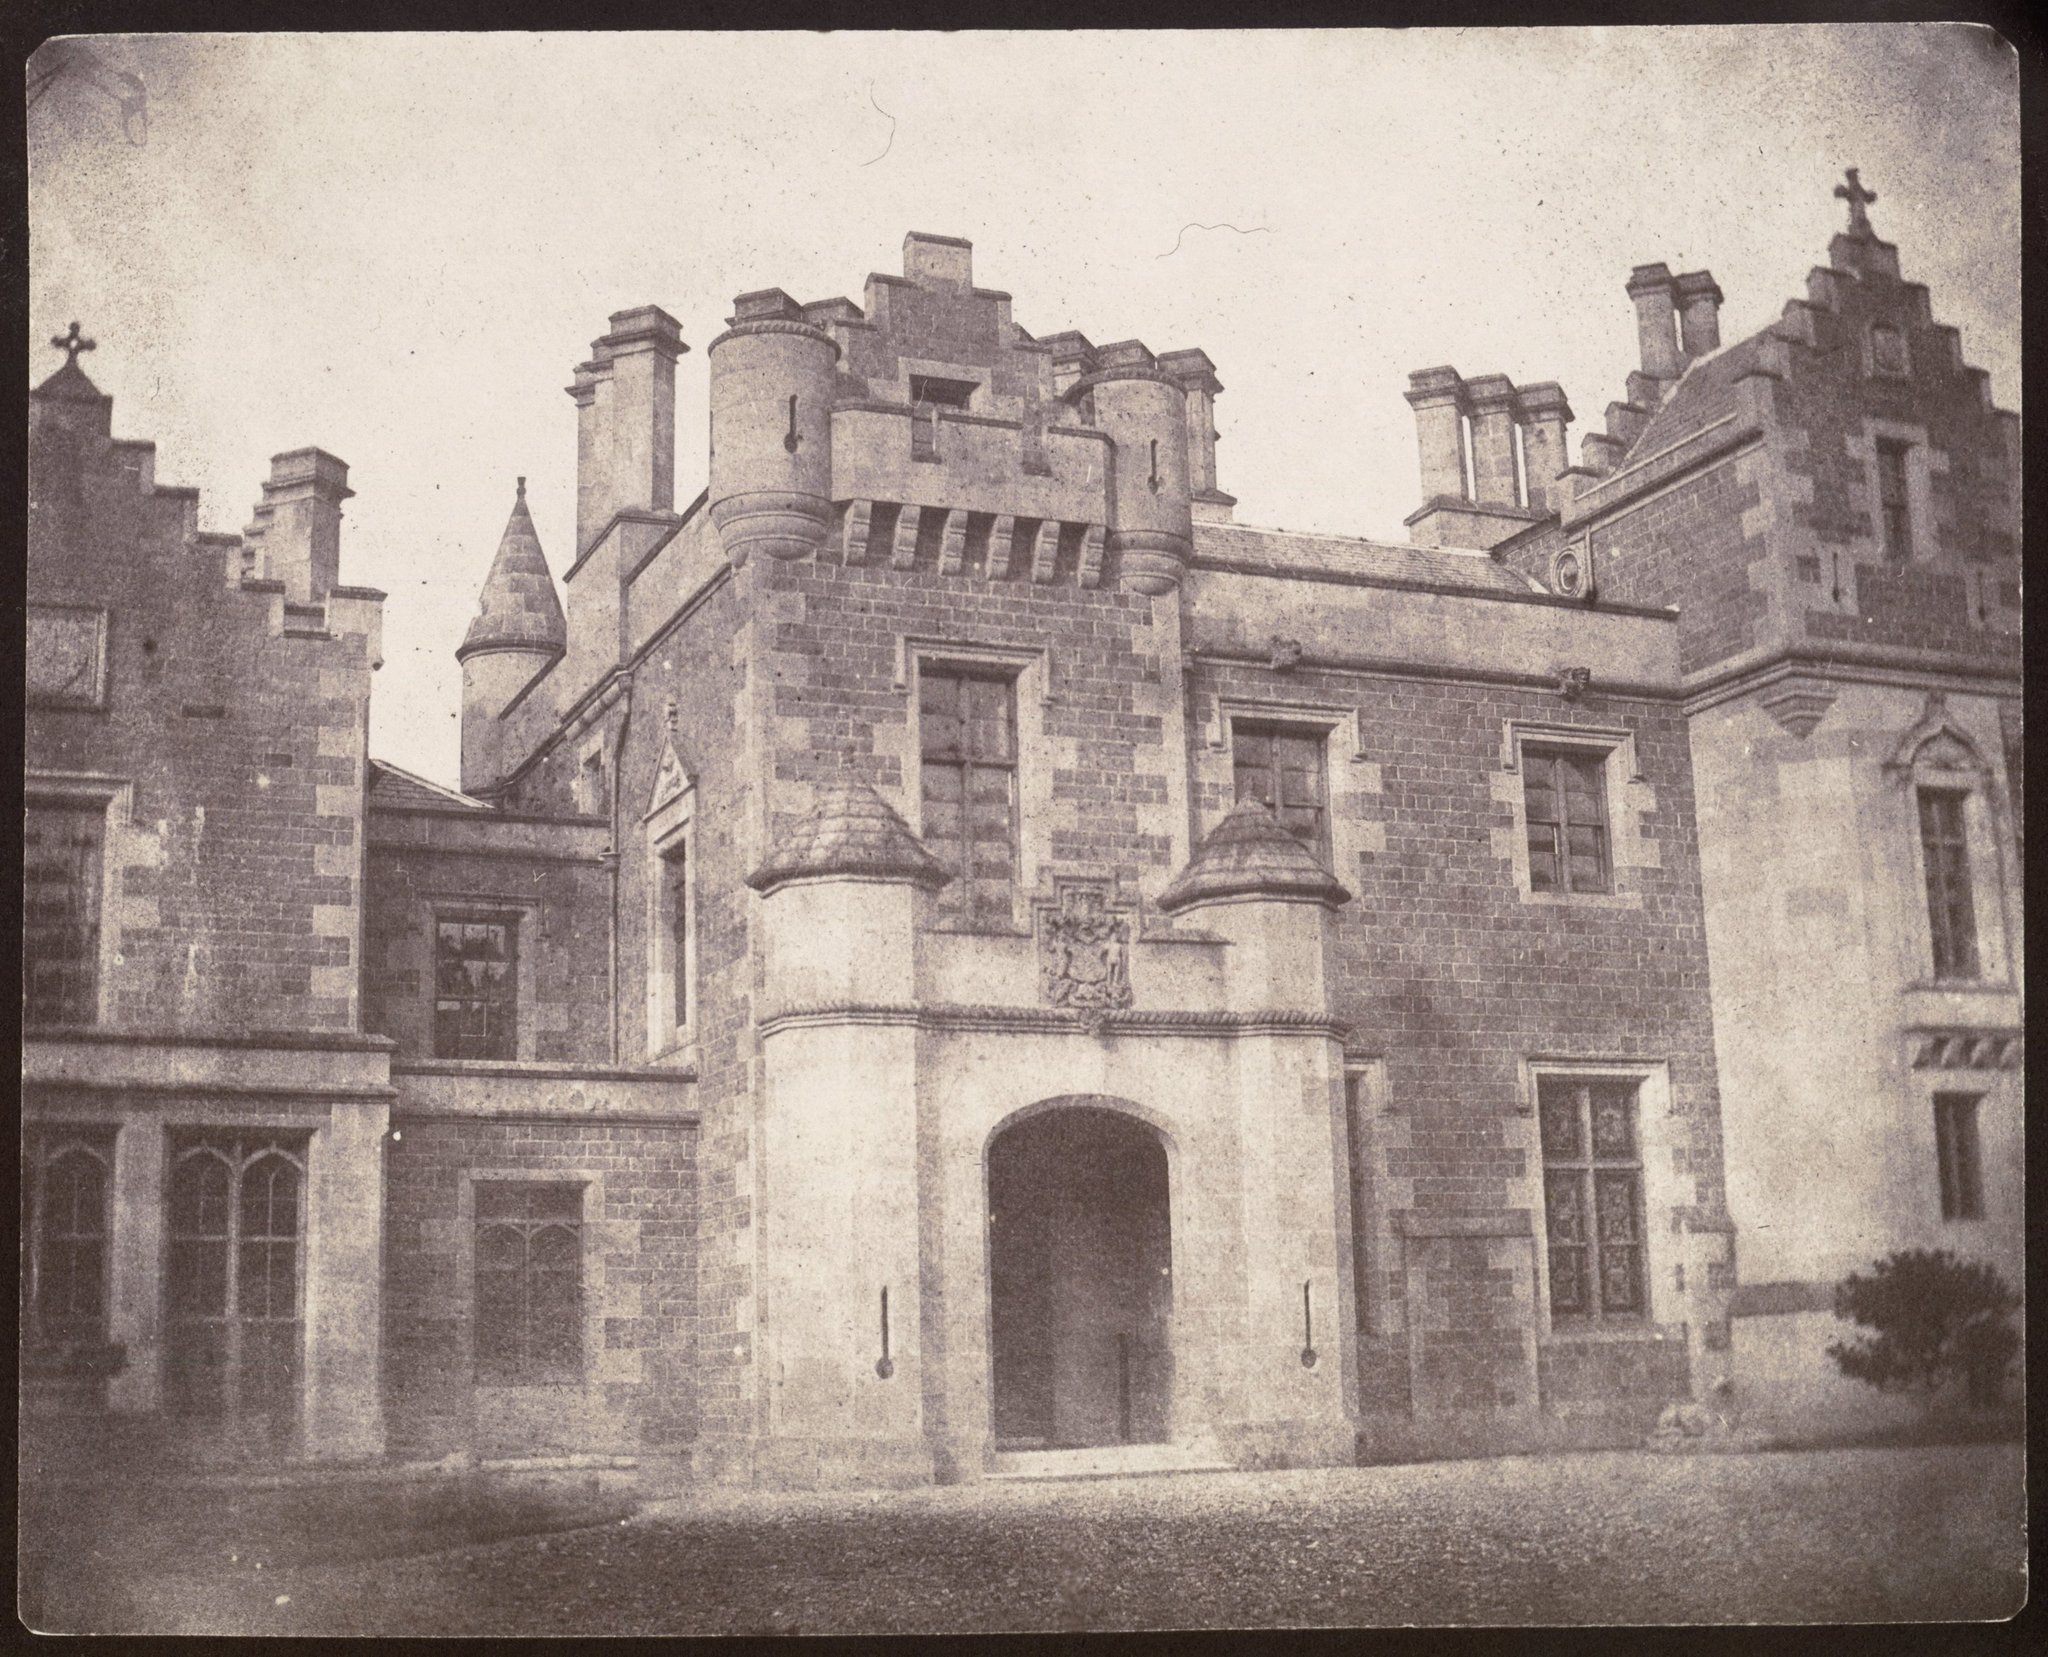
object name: photograph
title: Landhuis in Schotland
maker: william henry fox talbot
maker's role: fotograaf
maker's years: 1800-1877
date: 1845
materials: photographic support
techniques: salted paper print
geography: scotland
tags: rural housing, e.g. country-house, villa, cottage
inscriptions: watermark: ‘J WHATMAN TURKEY MILL 1840’